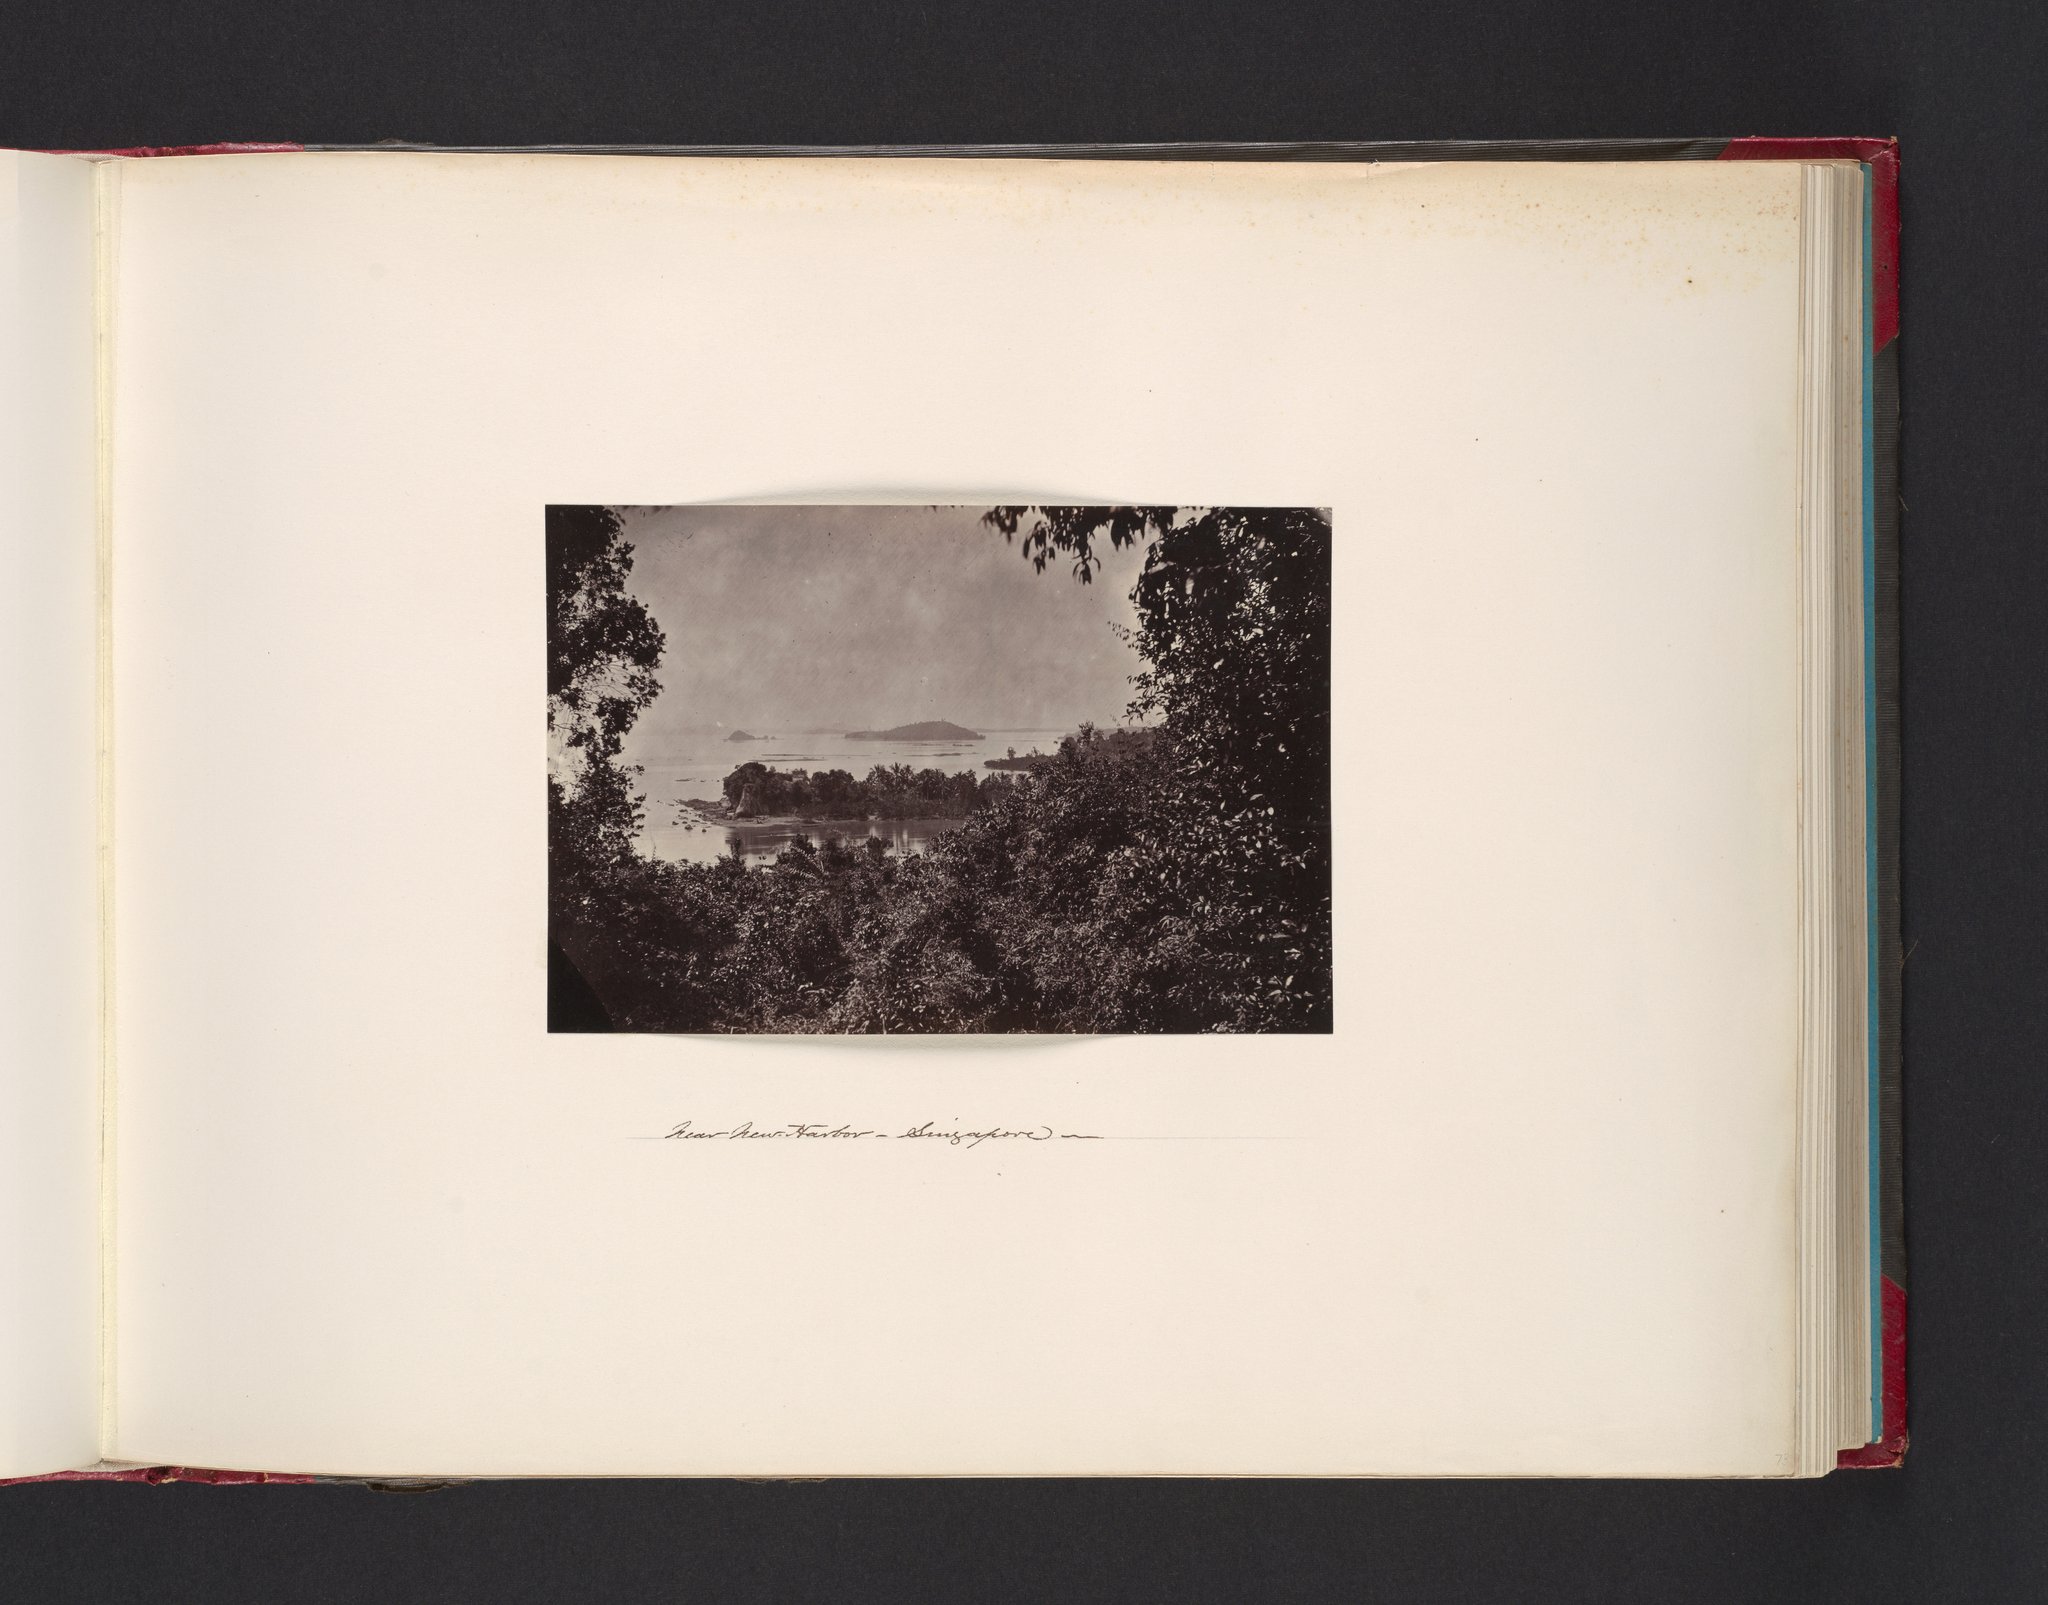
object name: photograph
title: Near New Harbor. Singapore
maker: john thomson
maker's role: artist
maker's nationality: british, scottish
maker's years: 1837-1921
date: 1865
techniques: albumen silver print, glass negative